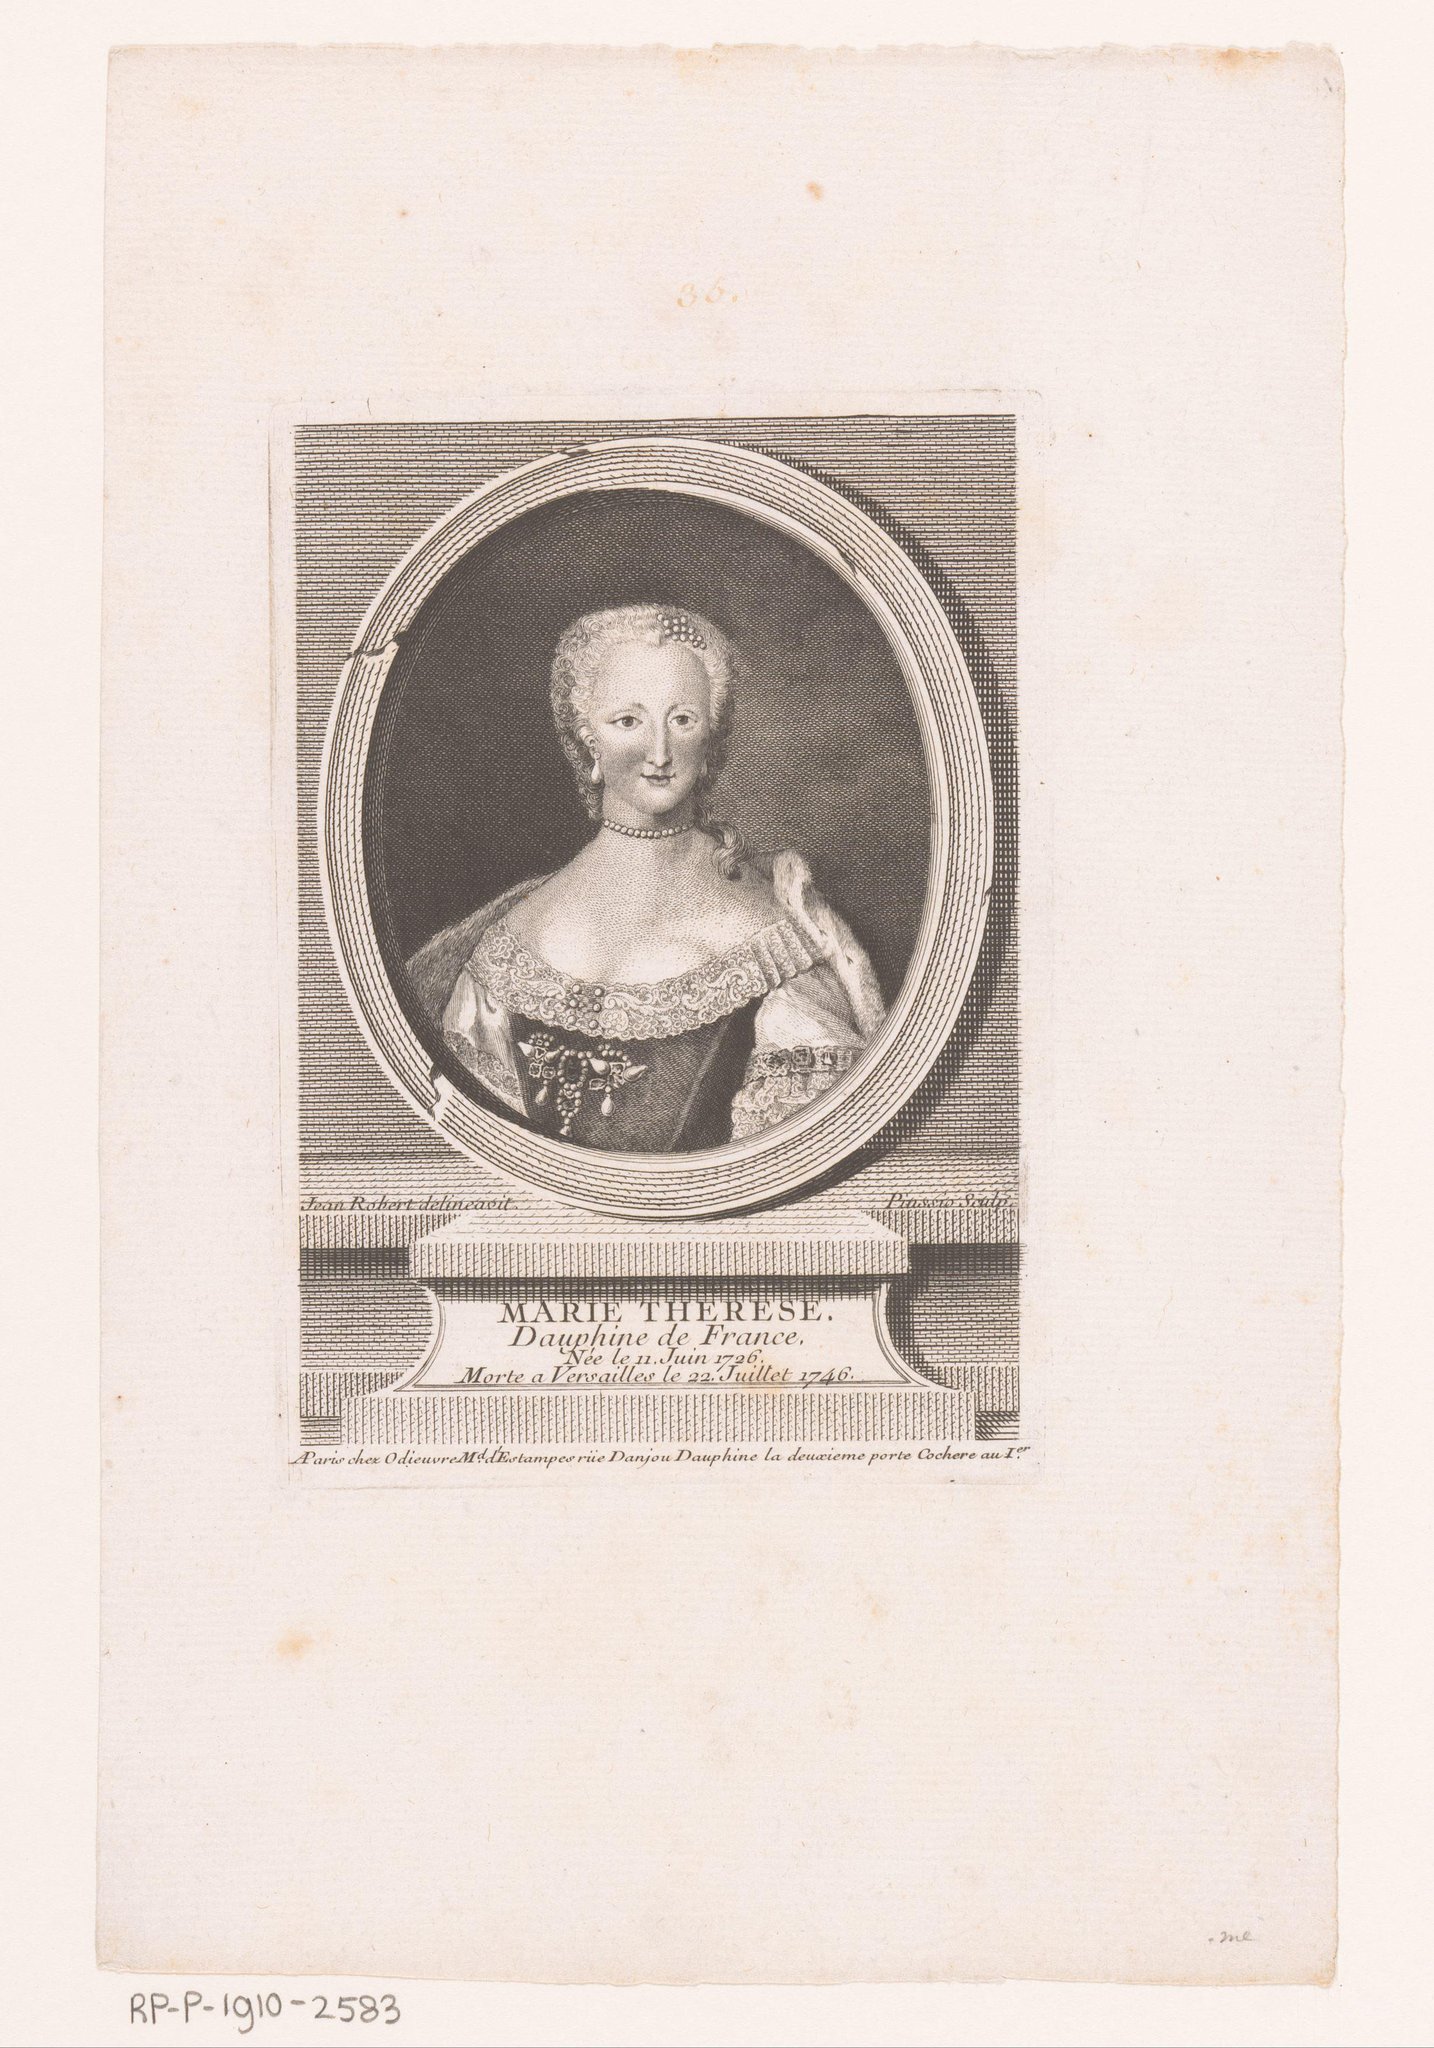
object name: print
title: Portret van Maria Theresia van Bourbon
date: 1755-1765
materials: paper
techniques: engraving, etching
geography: paris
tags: queen, empress, etc. (wife of a ruler), historical persons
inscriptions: collector's mark: Lugt 2228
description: Prent uit: Dreux du Radier, Jean-François. L'Europe illustré, contenant l'histoire abregée des souverains, des princes, des prélats, des ministres, (...) en Europe: dans le XVe. siècle compris, jusqu'à présent. Parijs: Michel Odieuvre en André-François Le Breton, 1755-1765.